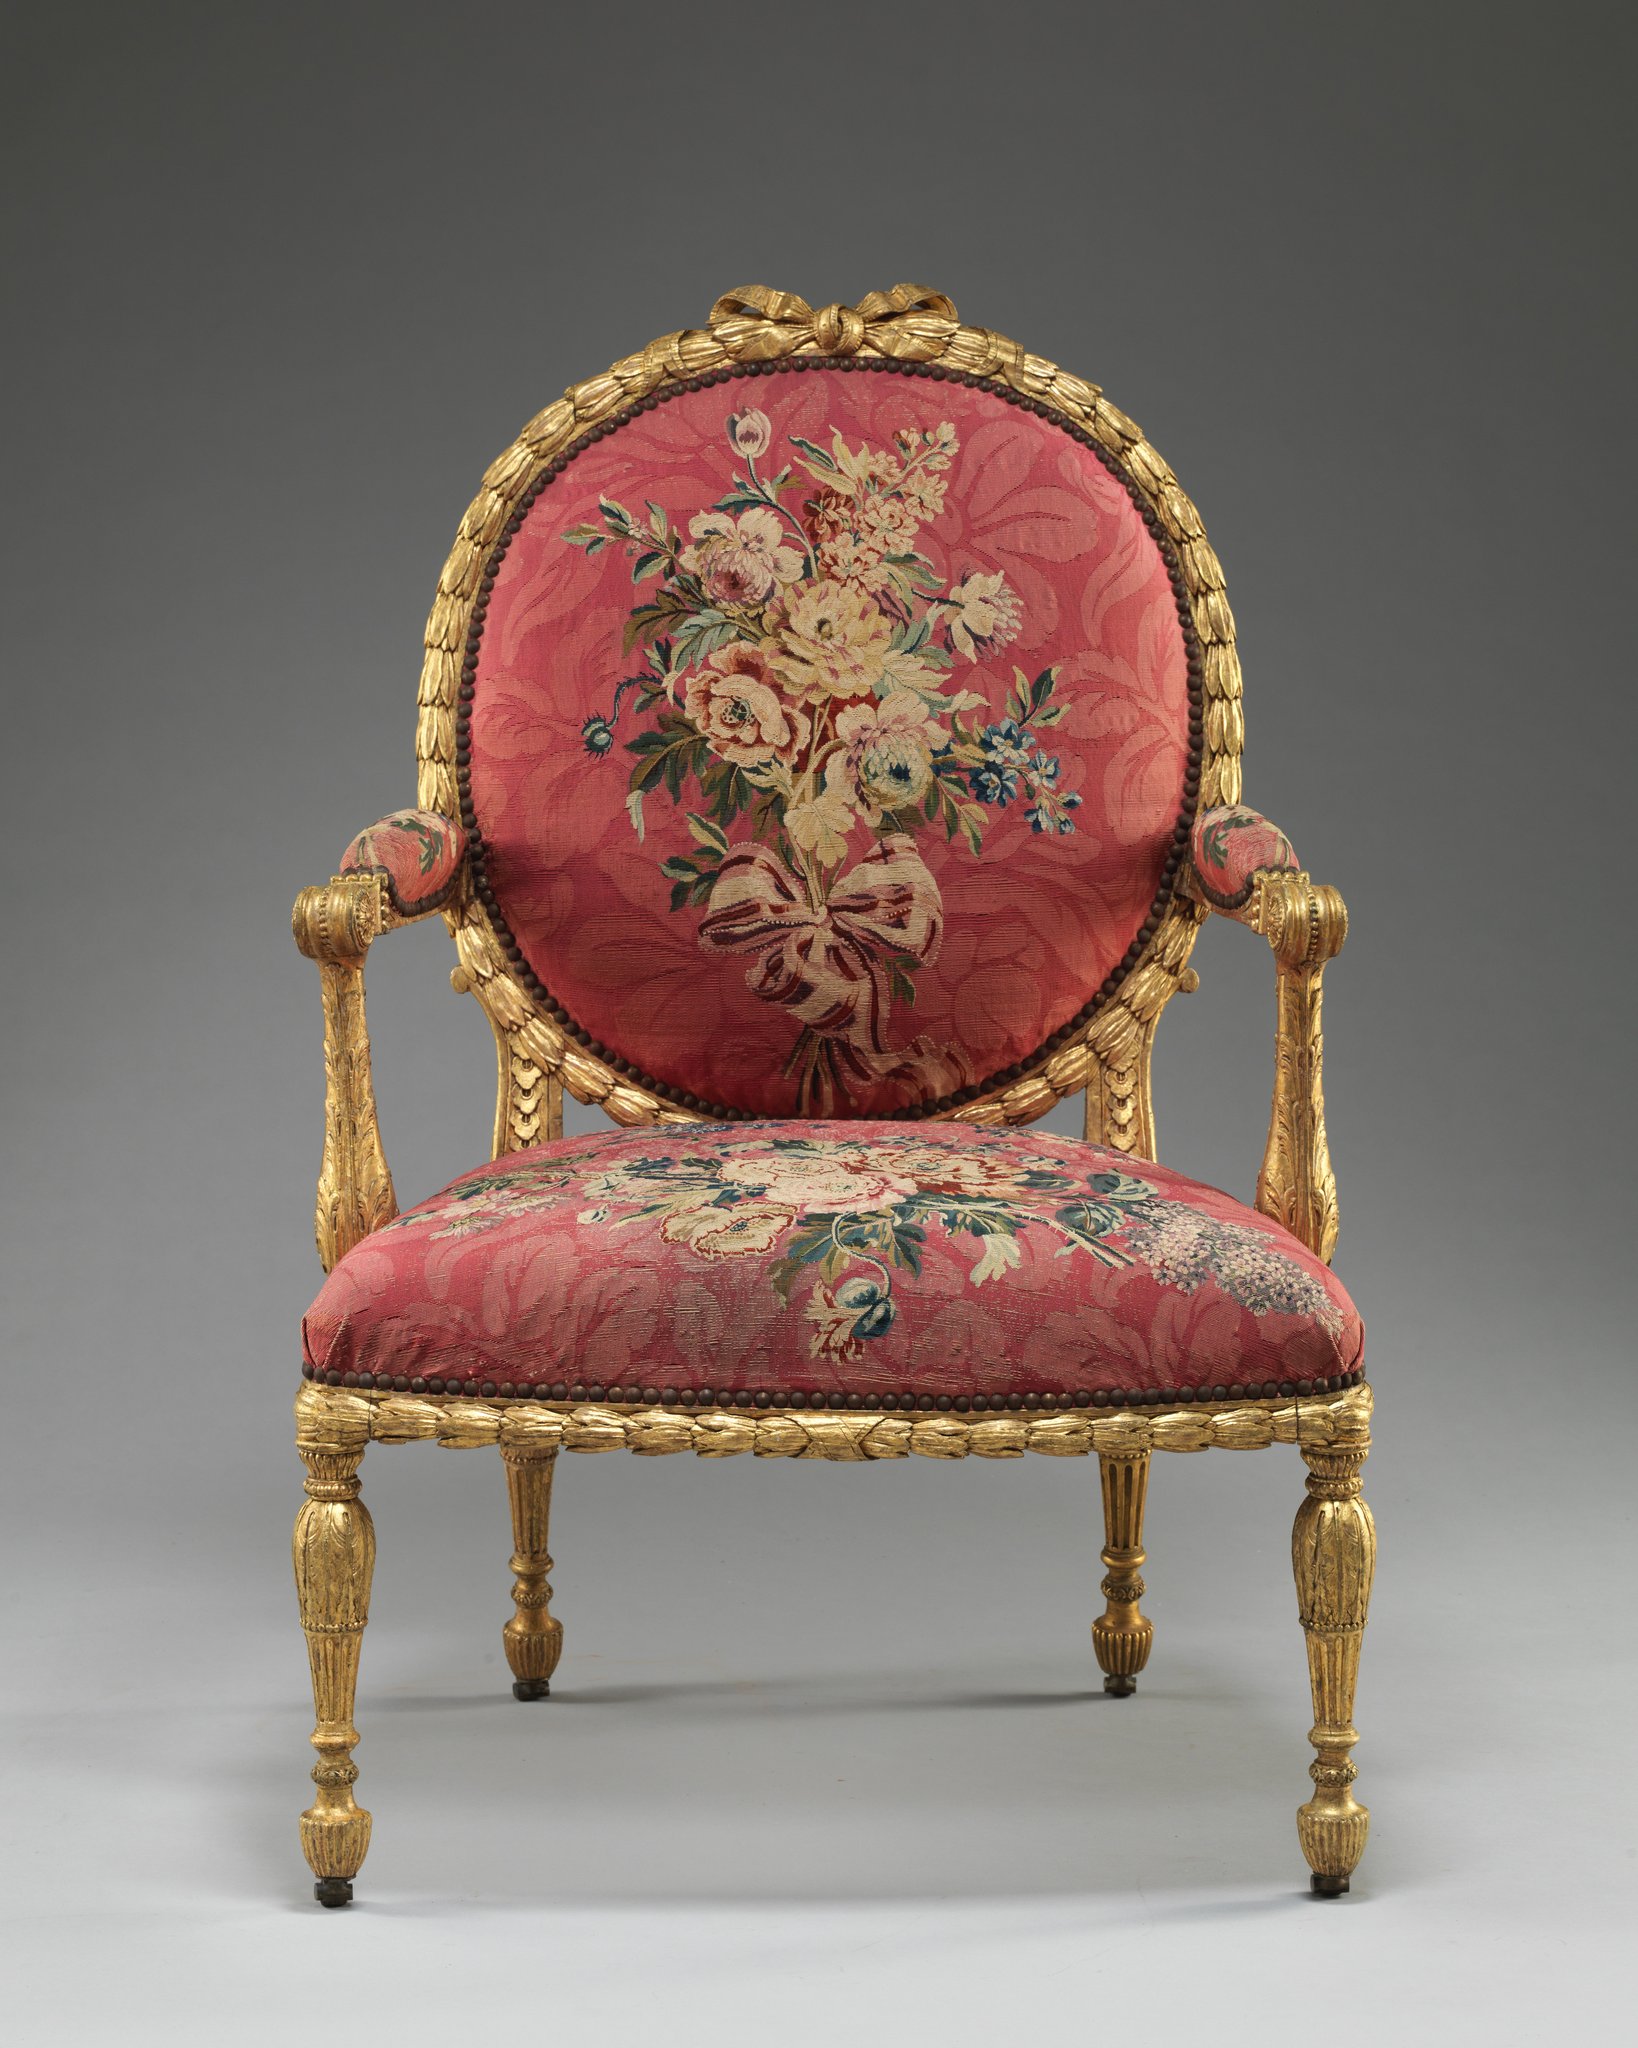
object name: armchair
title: Armchair (one of a set of six)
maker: john mayhew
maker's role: maker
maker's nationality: british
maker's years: 1736-1811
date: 1769-1771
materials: wood, silk, wool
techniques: gilding